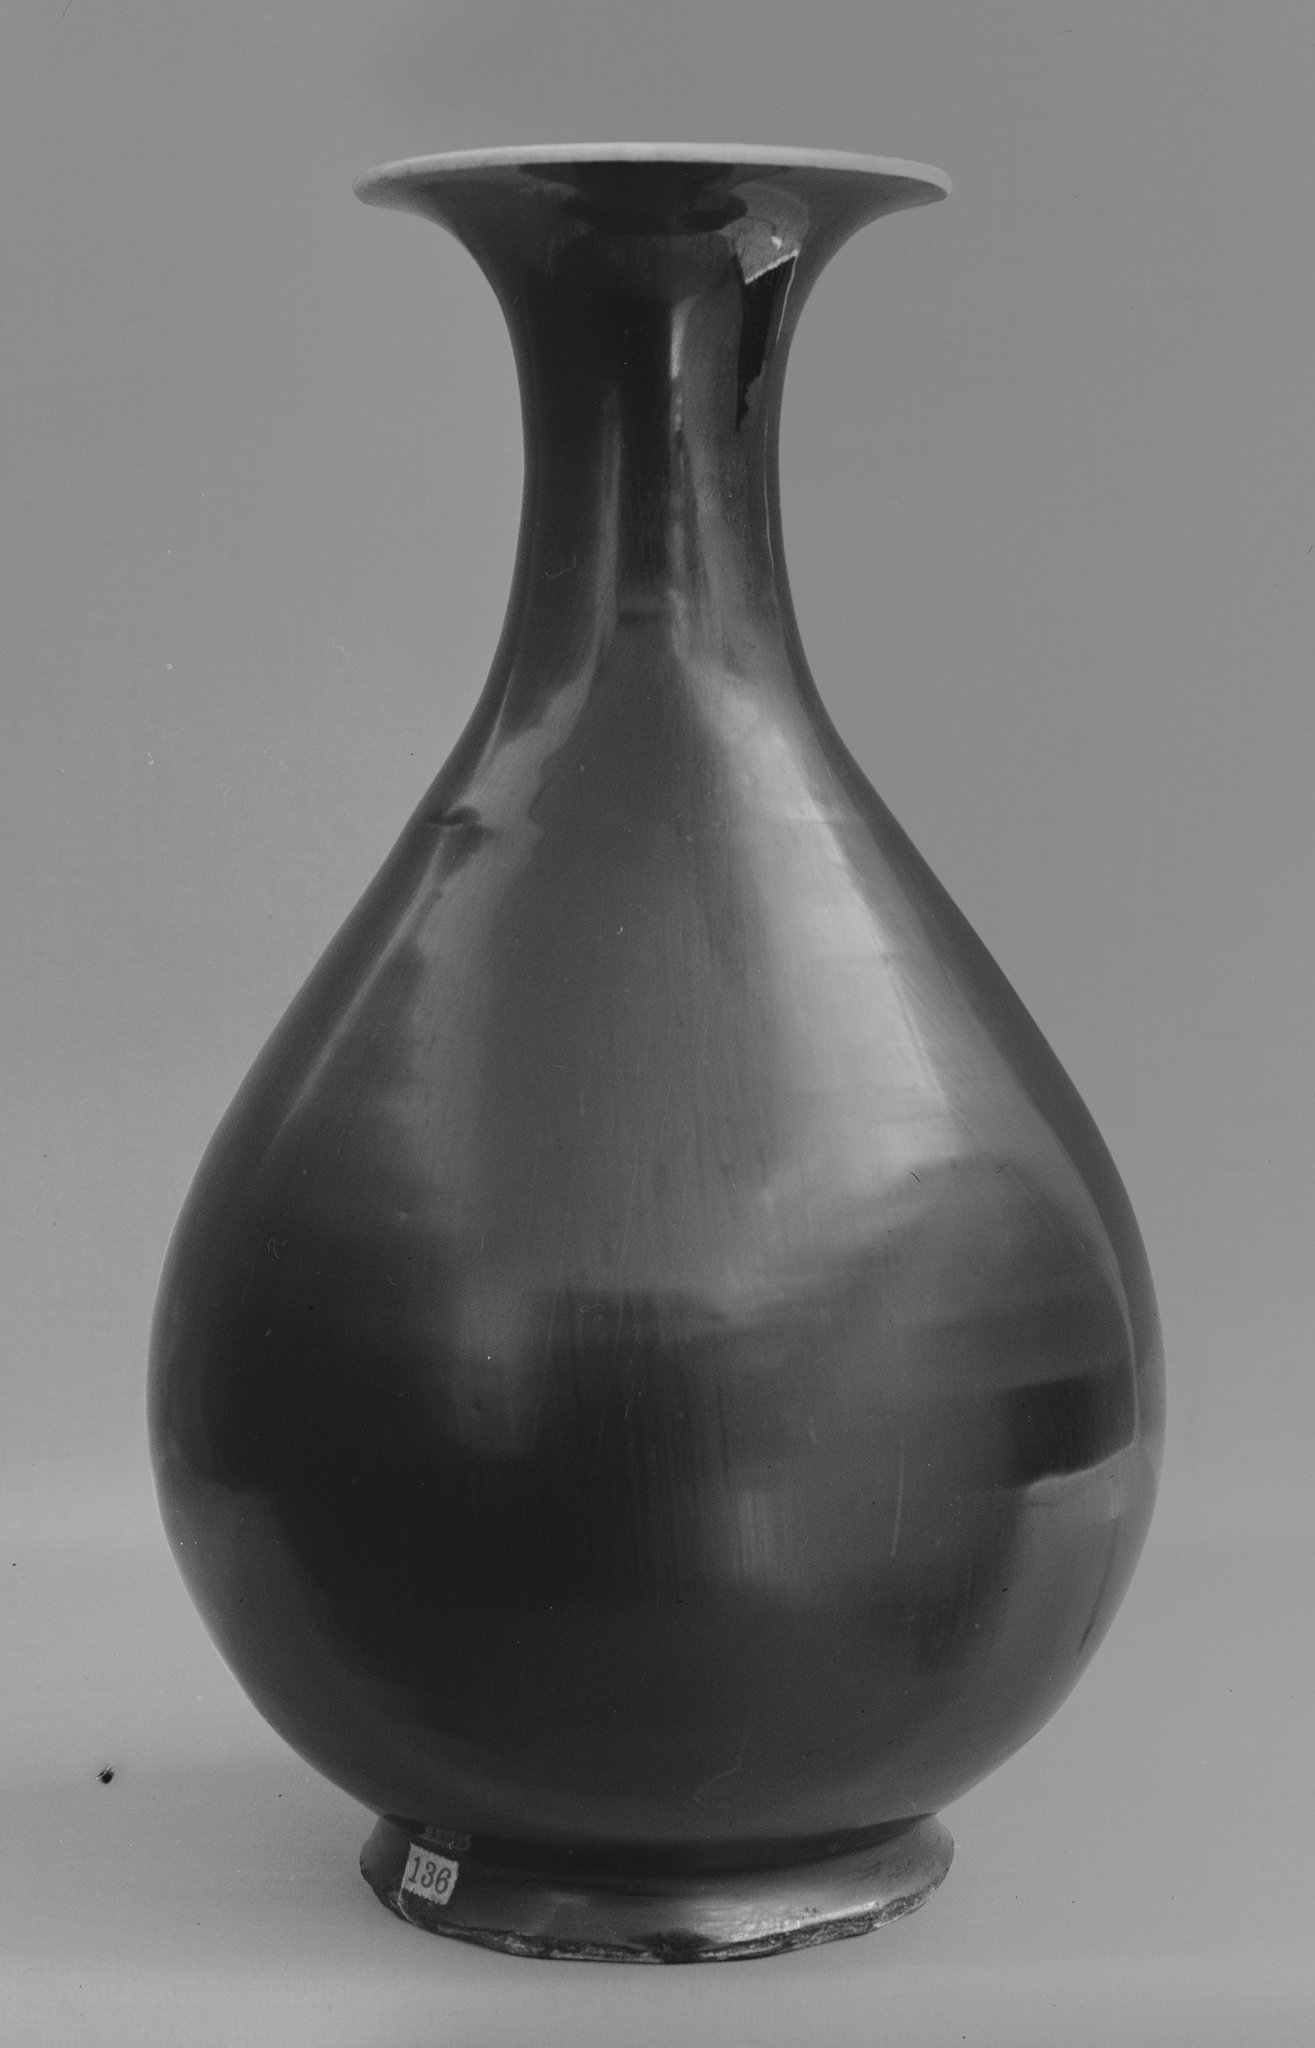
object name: vase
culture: chinese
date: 1767-1833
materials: glaze, porcelain